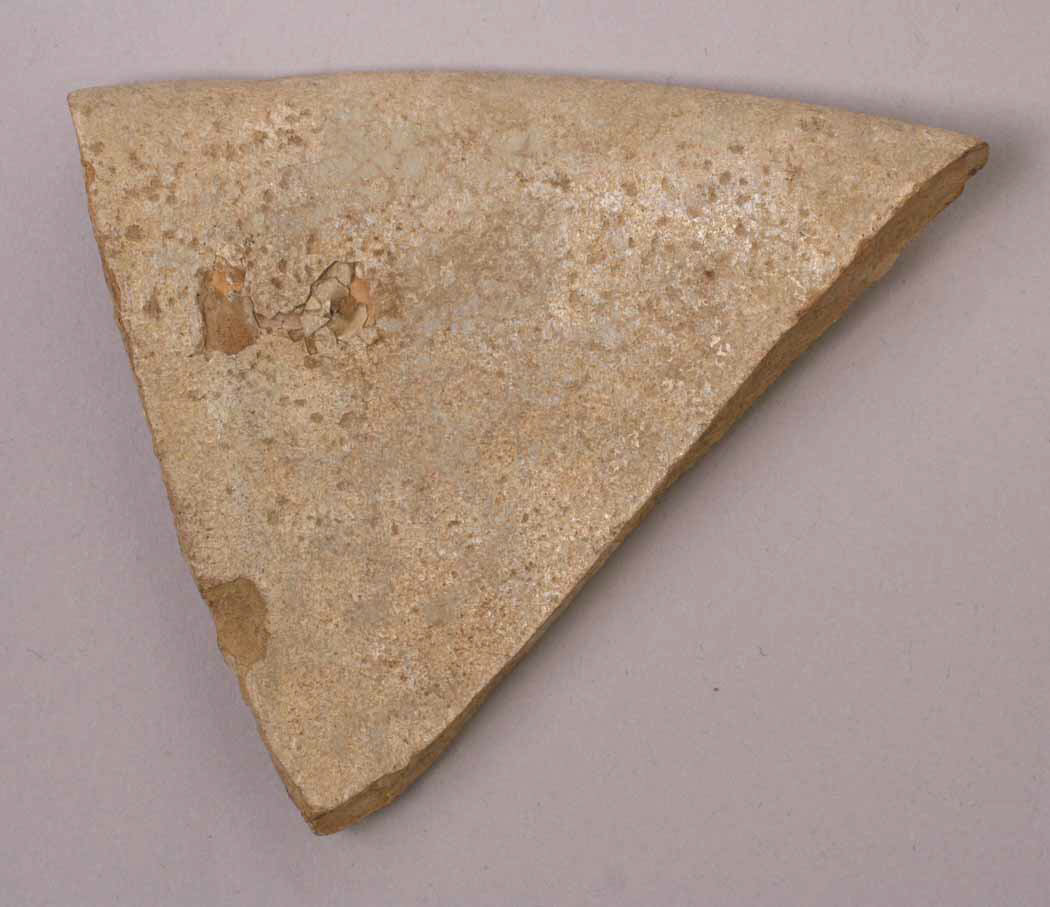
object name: fragment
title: Ceramic Fragment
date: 701-900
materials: earthenware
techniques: glazing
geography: iraq